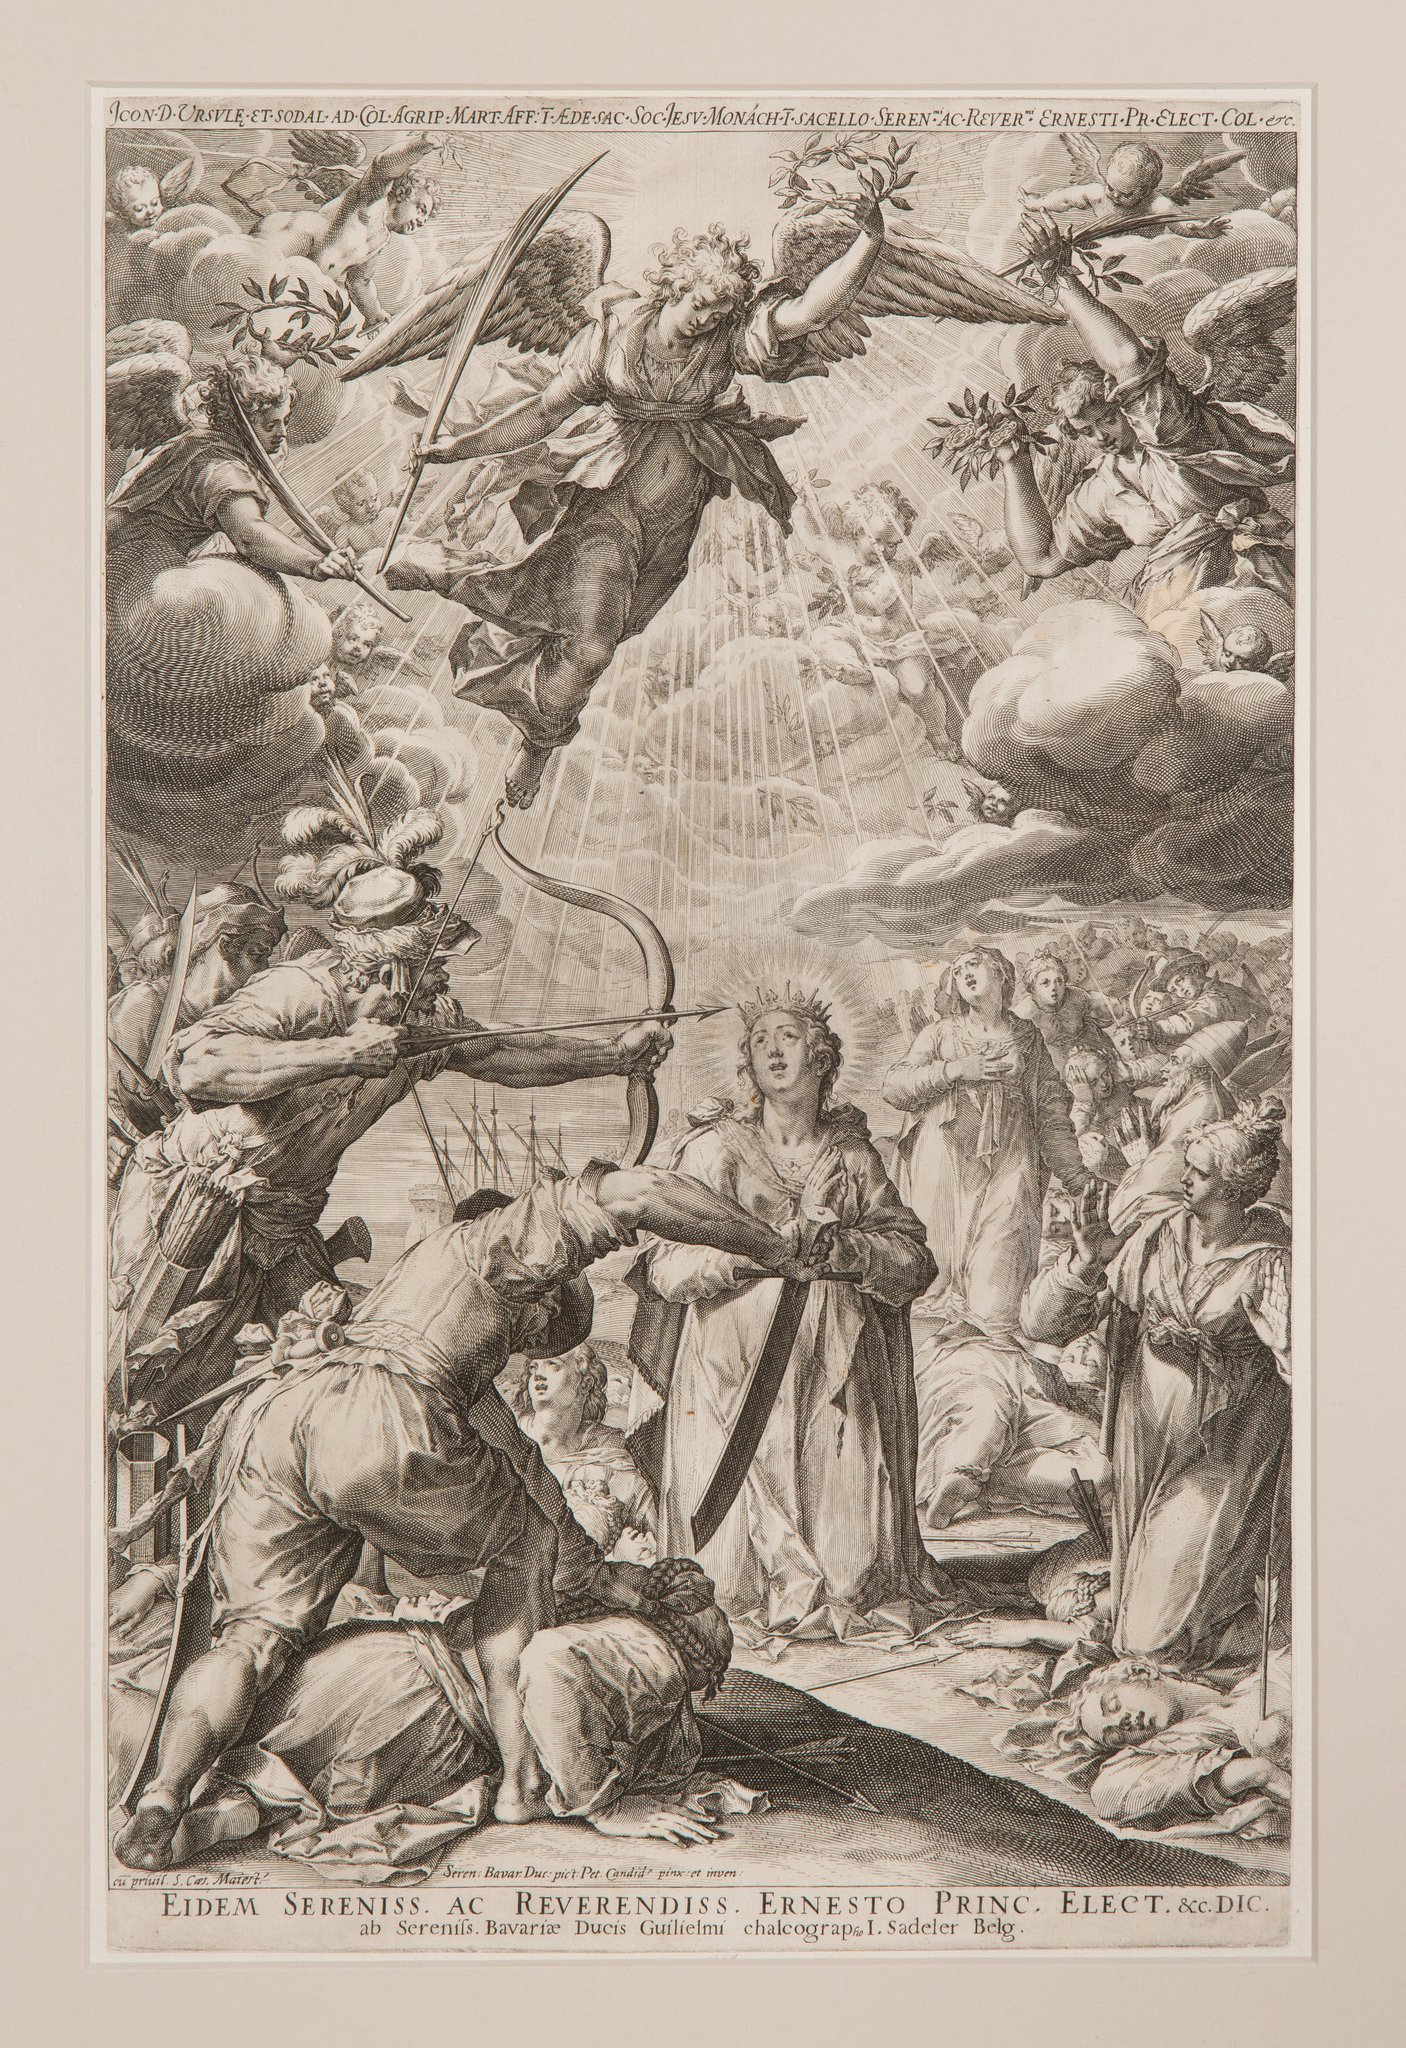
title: The Martyrdom of Saint Ursula and Her Companions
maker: johann sadeler (i)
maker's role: artist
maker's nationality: netherlandish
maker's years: 1550-1601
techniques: engraving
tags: bow and arrow,women,angels,saints